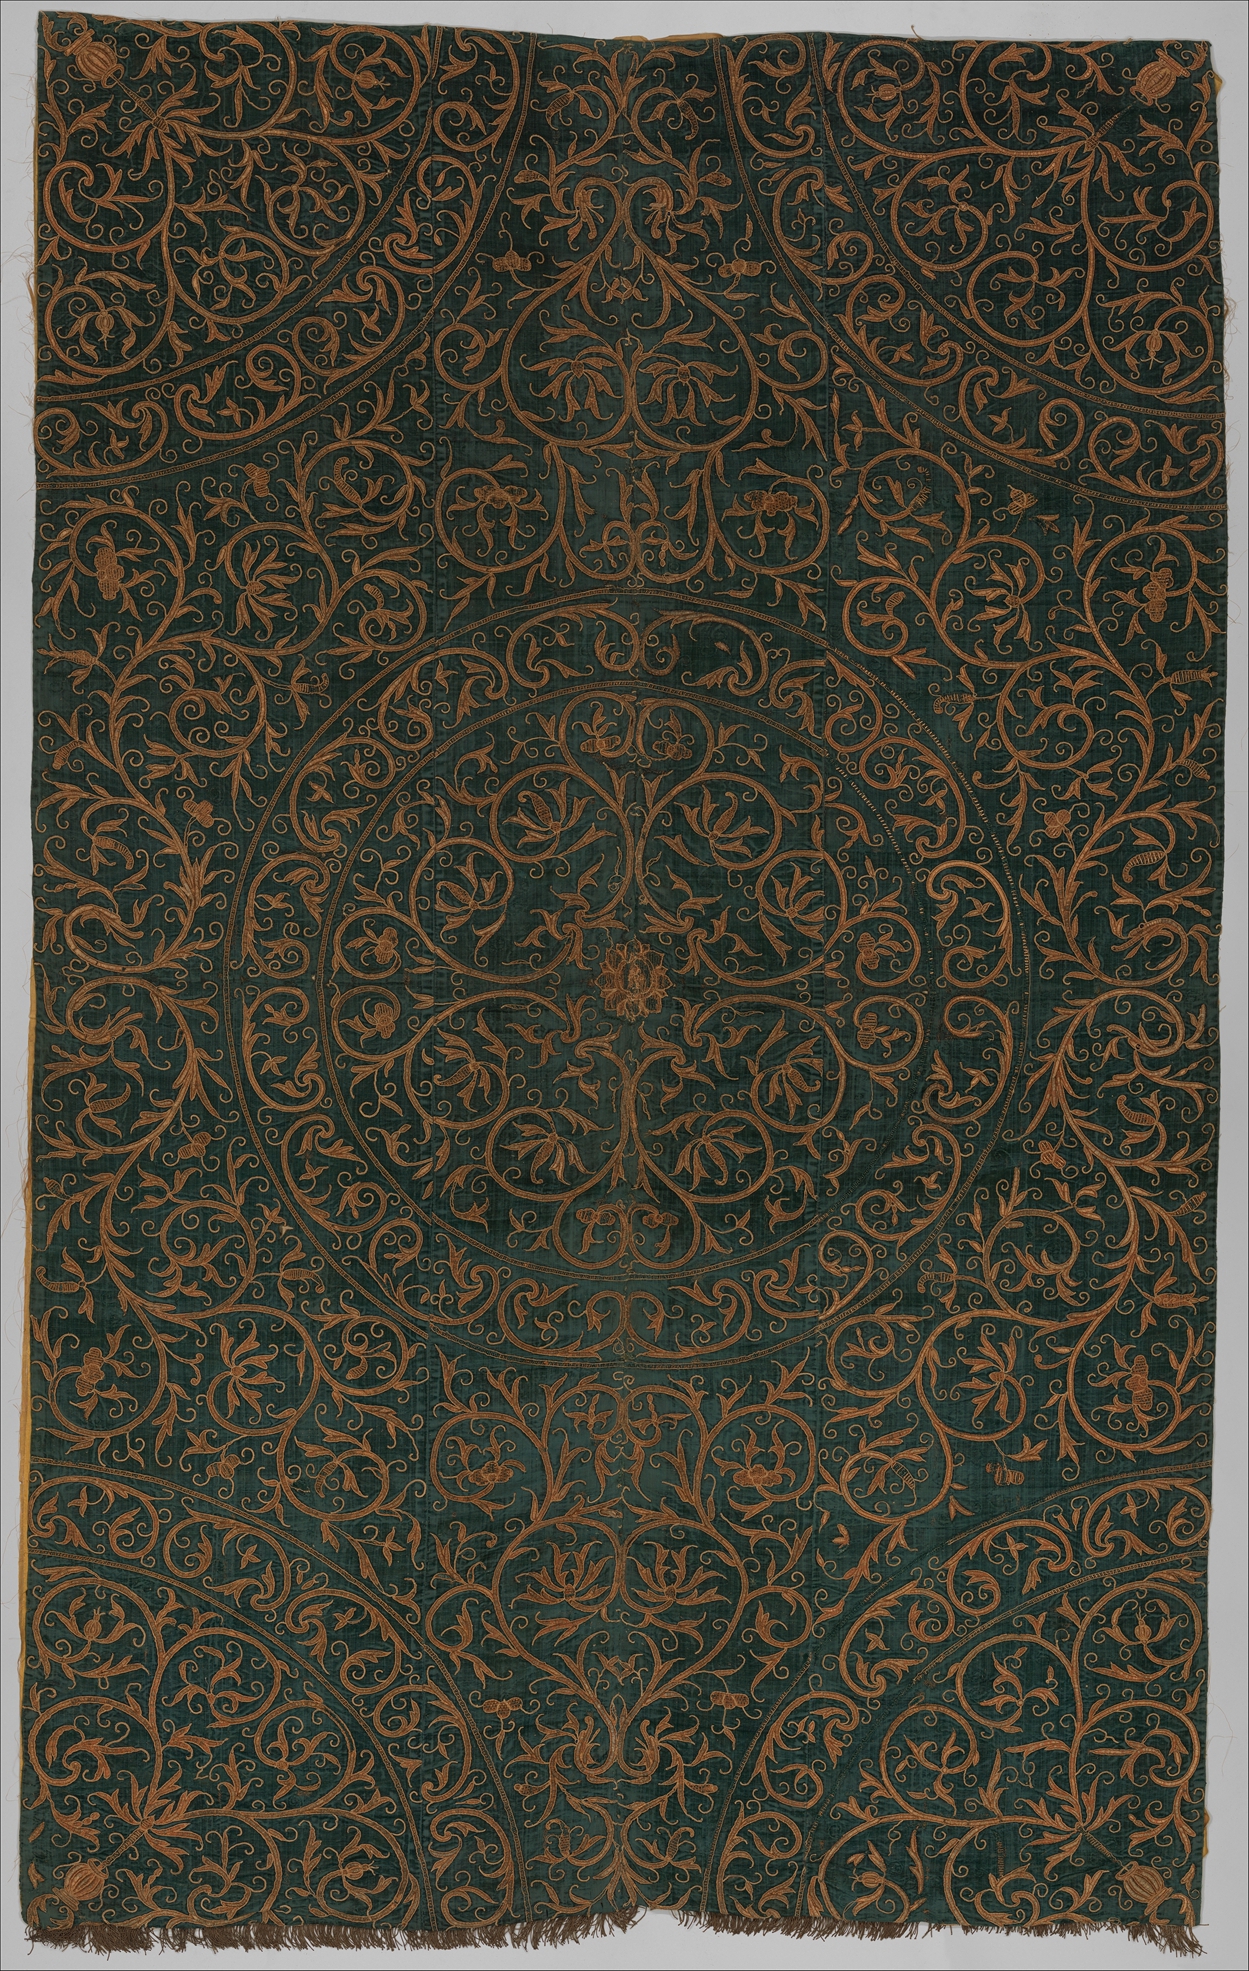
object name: curtain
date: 1601-1700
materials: gilt, thread, velvet